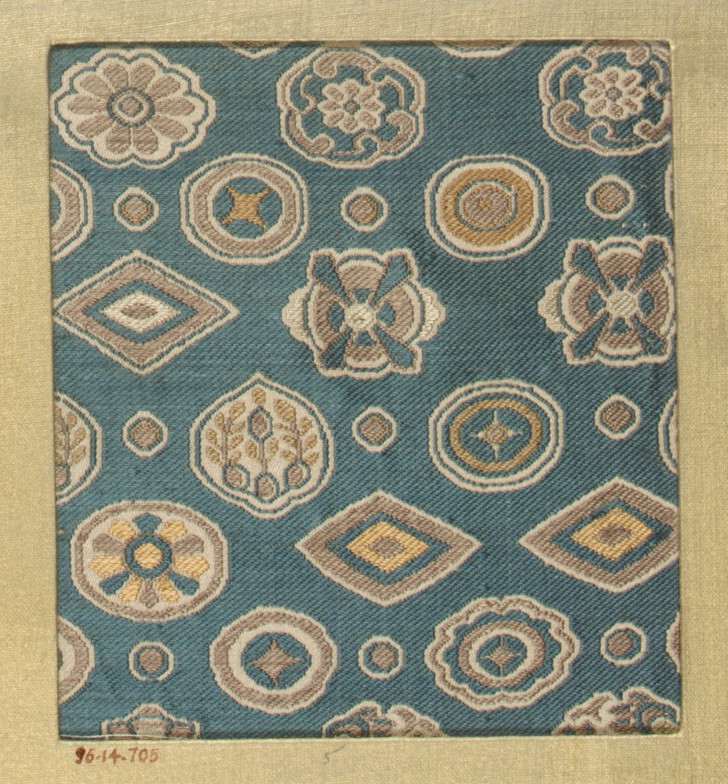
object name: piece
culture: japanese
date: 1701-1900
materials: silk